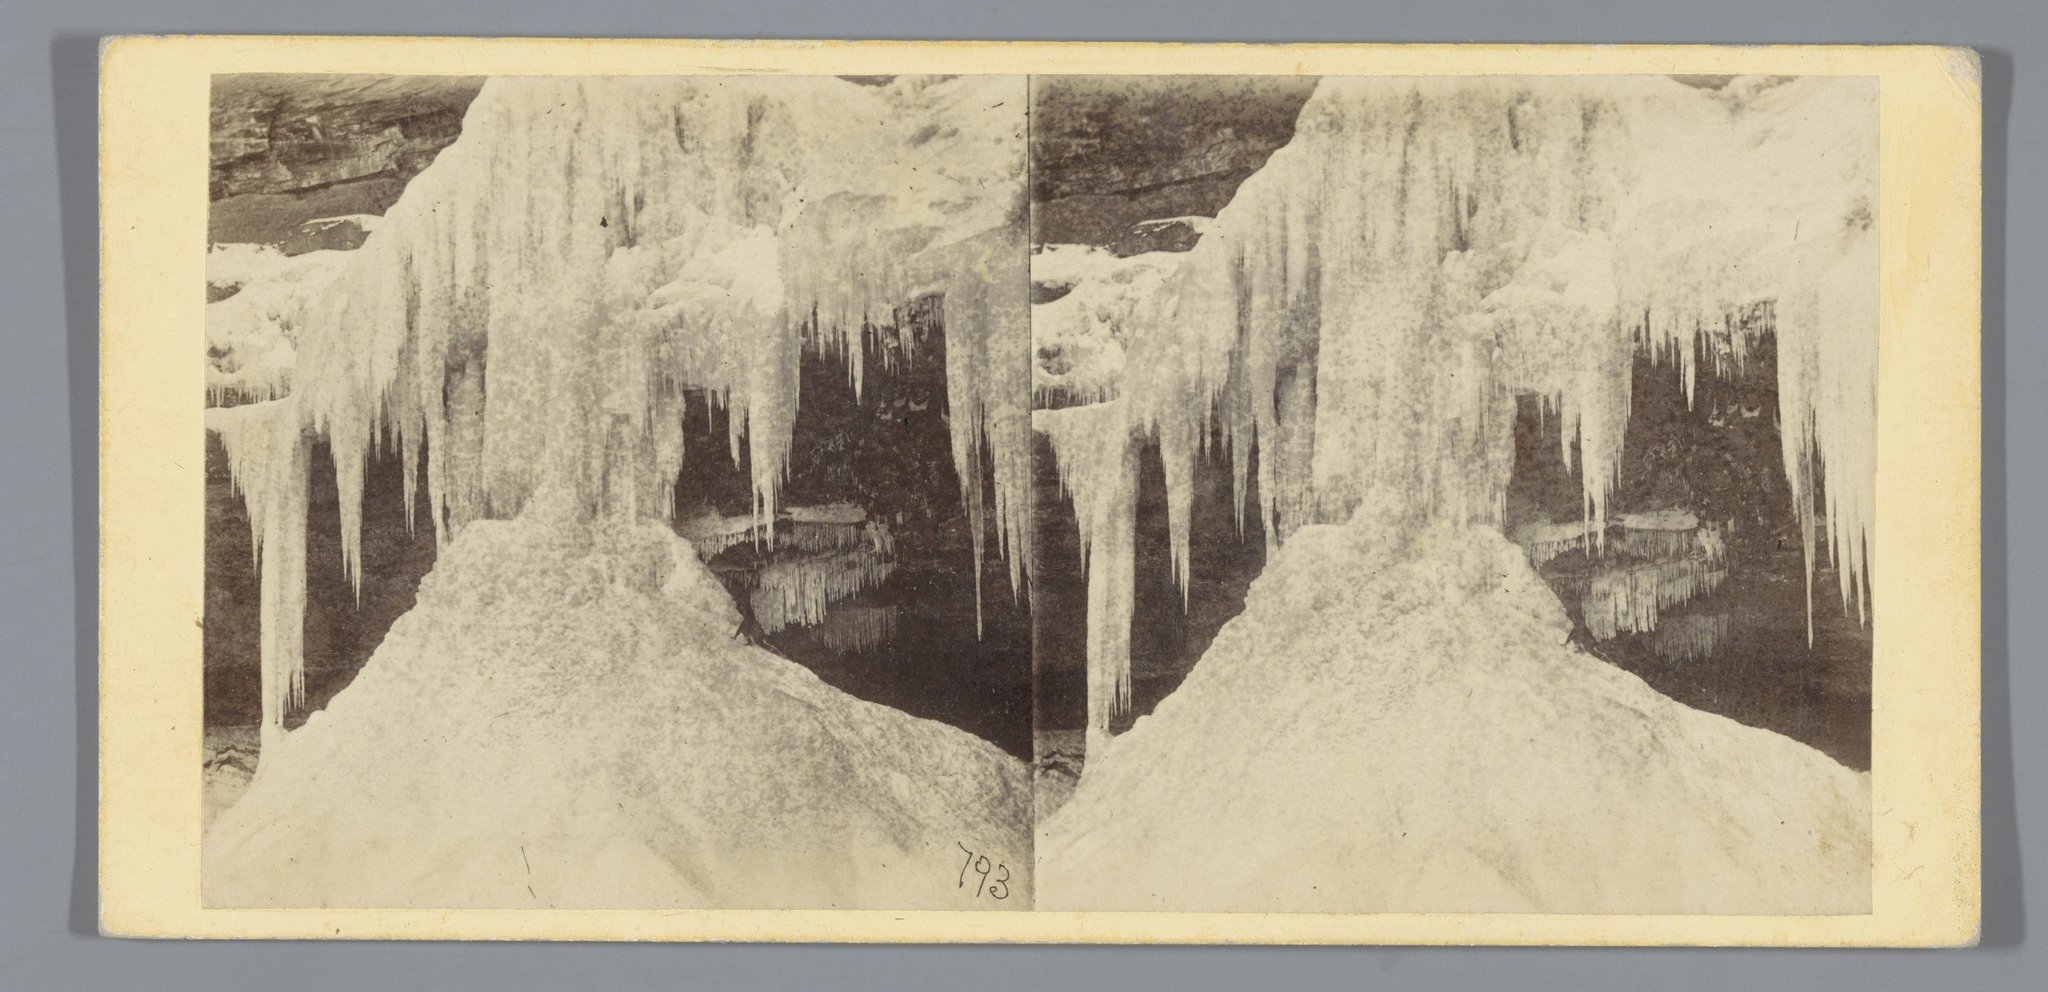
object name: stereograph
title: IJsformaties in het Catskillgebergte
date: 1857-1862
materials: cardboard, paper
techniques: albumen print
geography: catskill mountains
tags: stalactitic cave, icicle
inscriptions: address: ‘501 Broadway, New-York’, : ‘These are some (...) selection from them.’, inscription: ‘/1111’, number: ‘793’